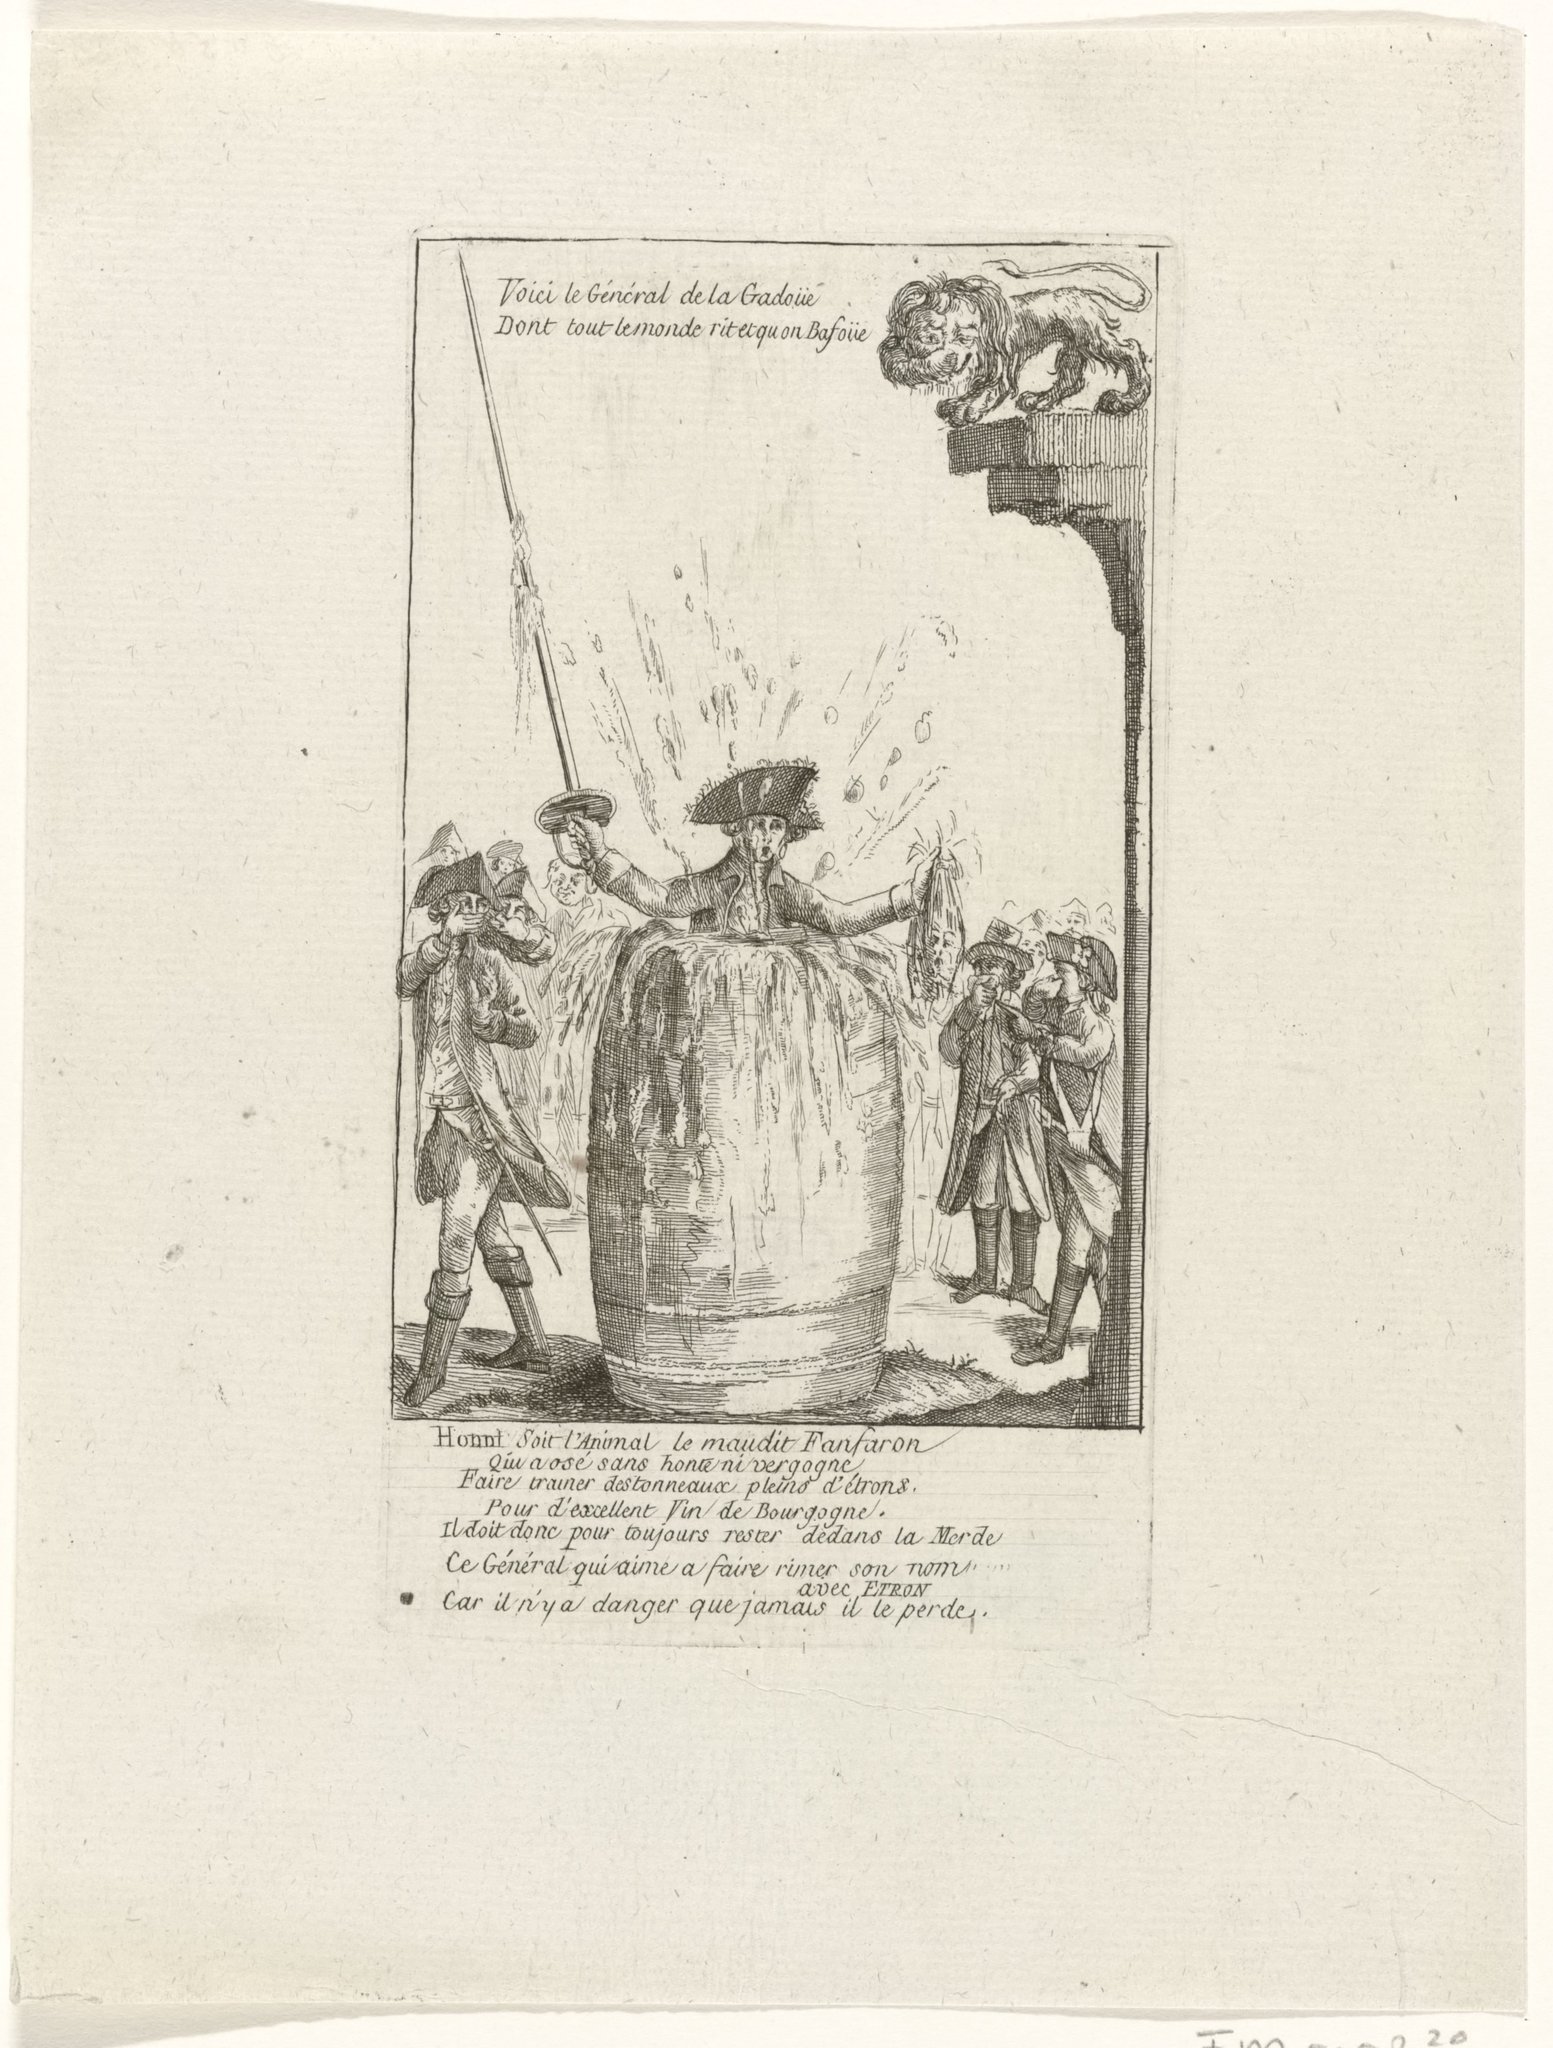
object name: cartoon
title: Generaal in een ton met drek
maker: Anonymous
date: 1787-1790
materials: paper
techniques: engraving, etching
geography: southern netherlands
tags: defecation, brabant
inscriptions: collector's mark: Lugt 2228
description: Spotprent op een generaal die met getrokken zwaard en afgehakte mensenhoofden in een vat met drek staat. Omstanders en de Brabantse leeuw kijken toe en knijpen hun neus dicht. Met zevenregelig Frans vers. Onderdeel van een grote groep van prenten betrekking hebbend op de gebeurtenissen van de Brabantse Omwenteling en de periode 1787-1790.